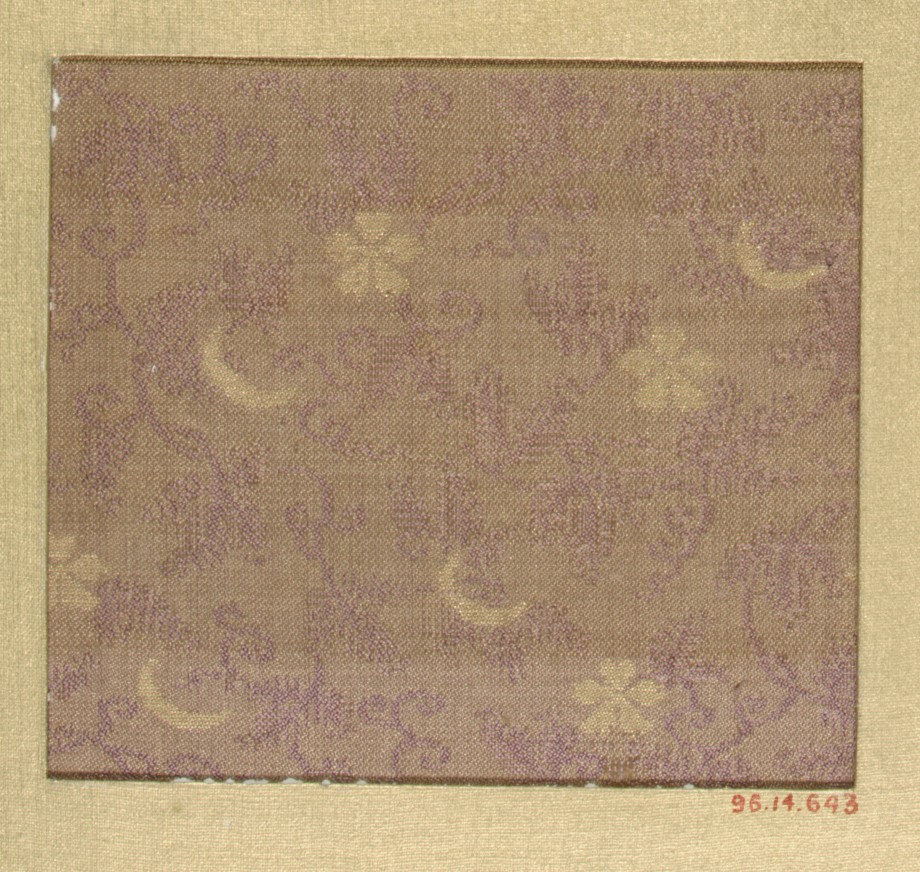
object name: piece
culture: japanese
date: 1701-1900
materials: silk